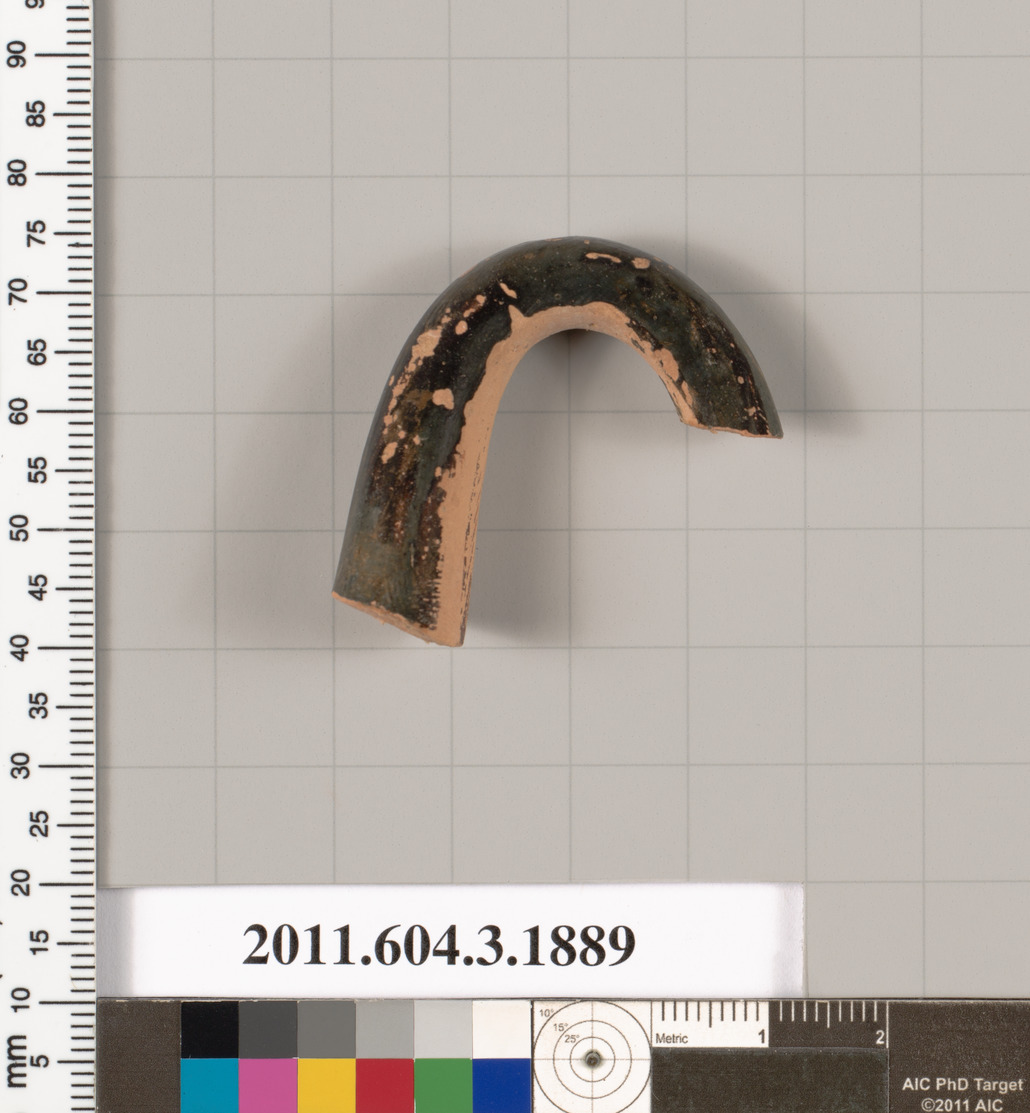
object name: kylix or skyphos fragment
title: Terracotta fragment of a kylix (drinking cup) or a skyphos (deep drinking cup)?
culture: greek, attic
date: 600-401 BCE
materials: terracotta